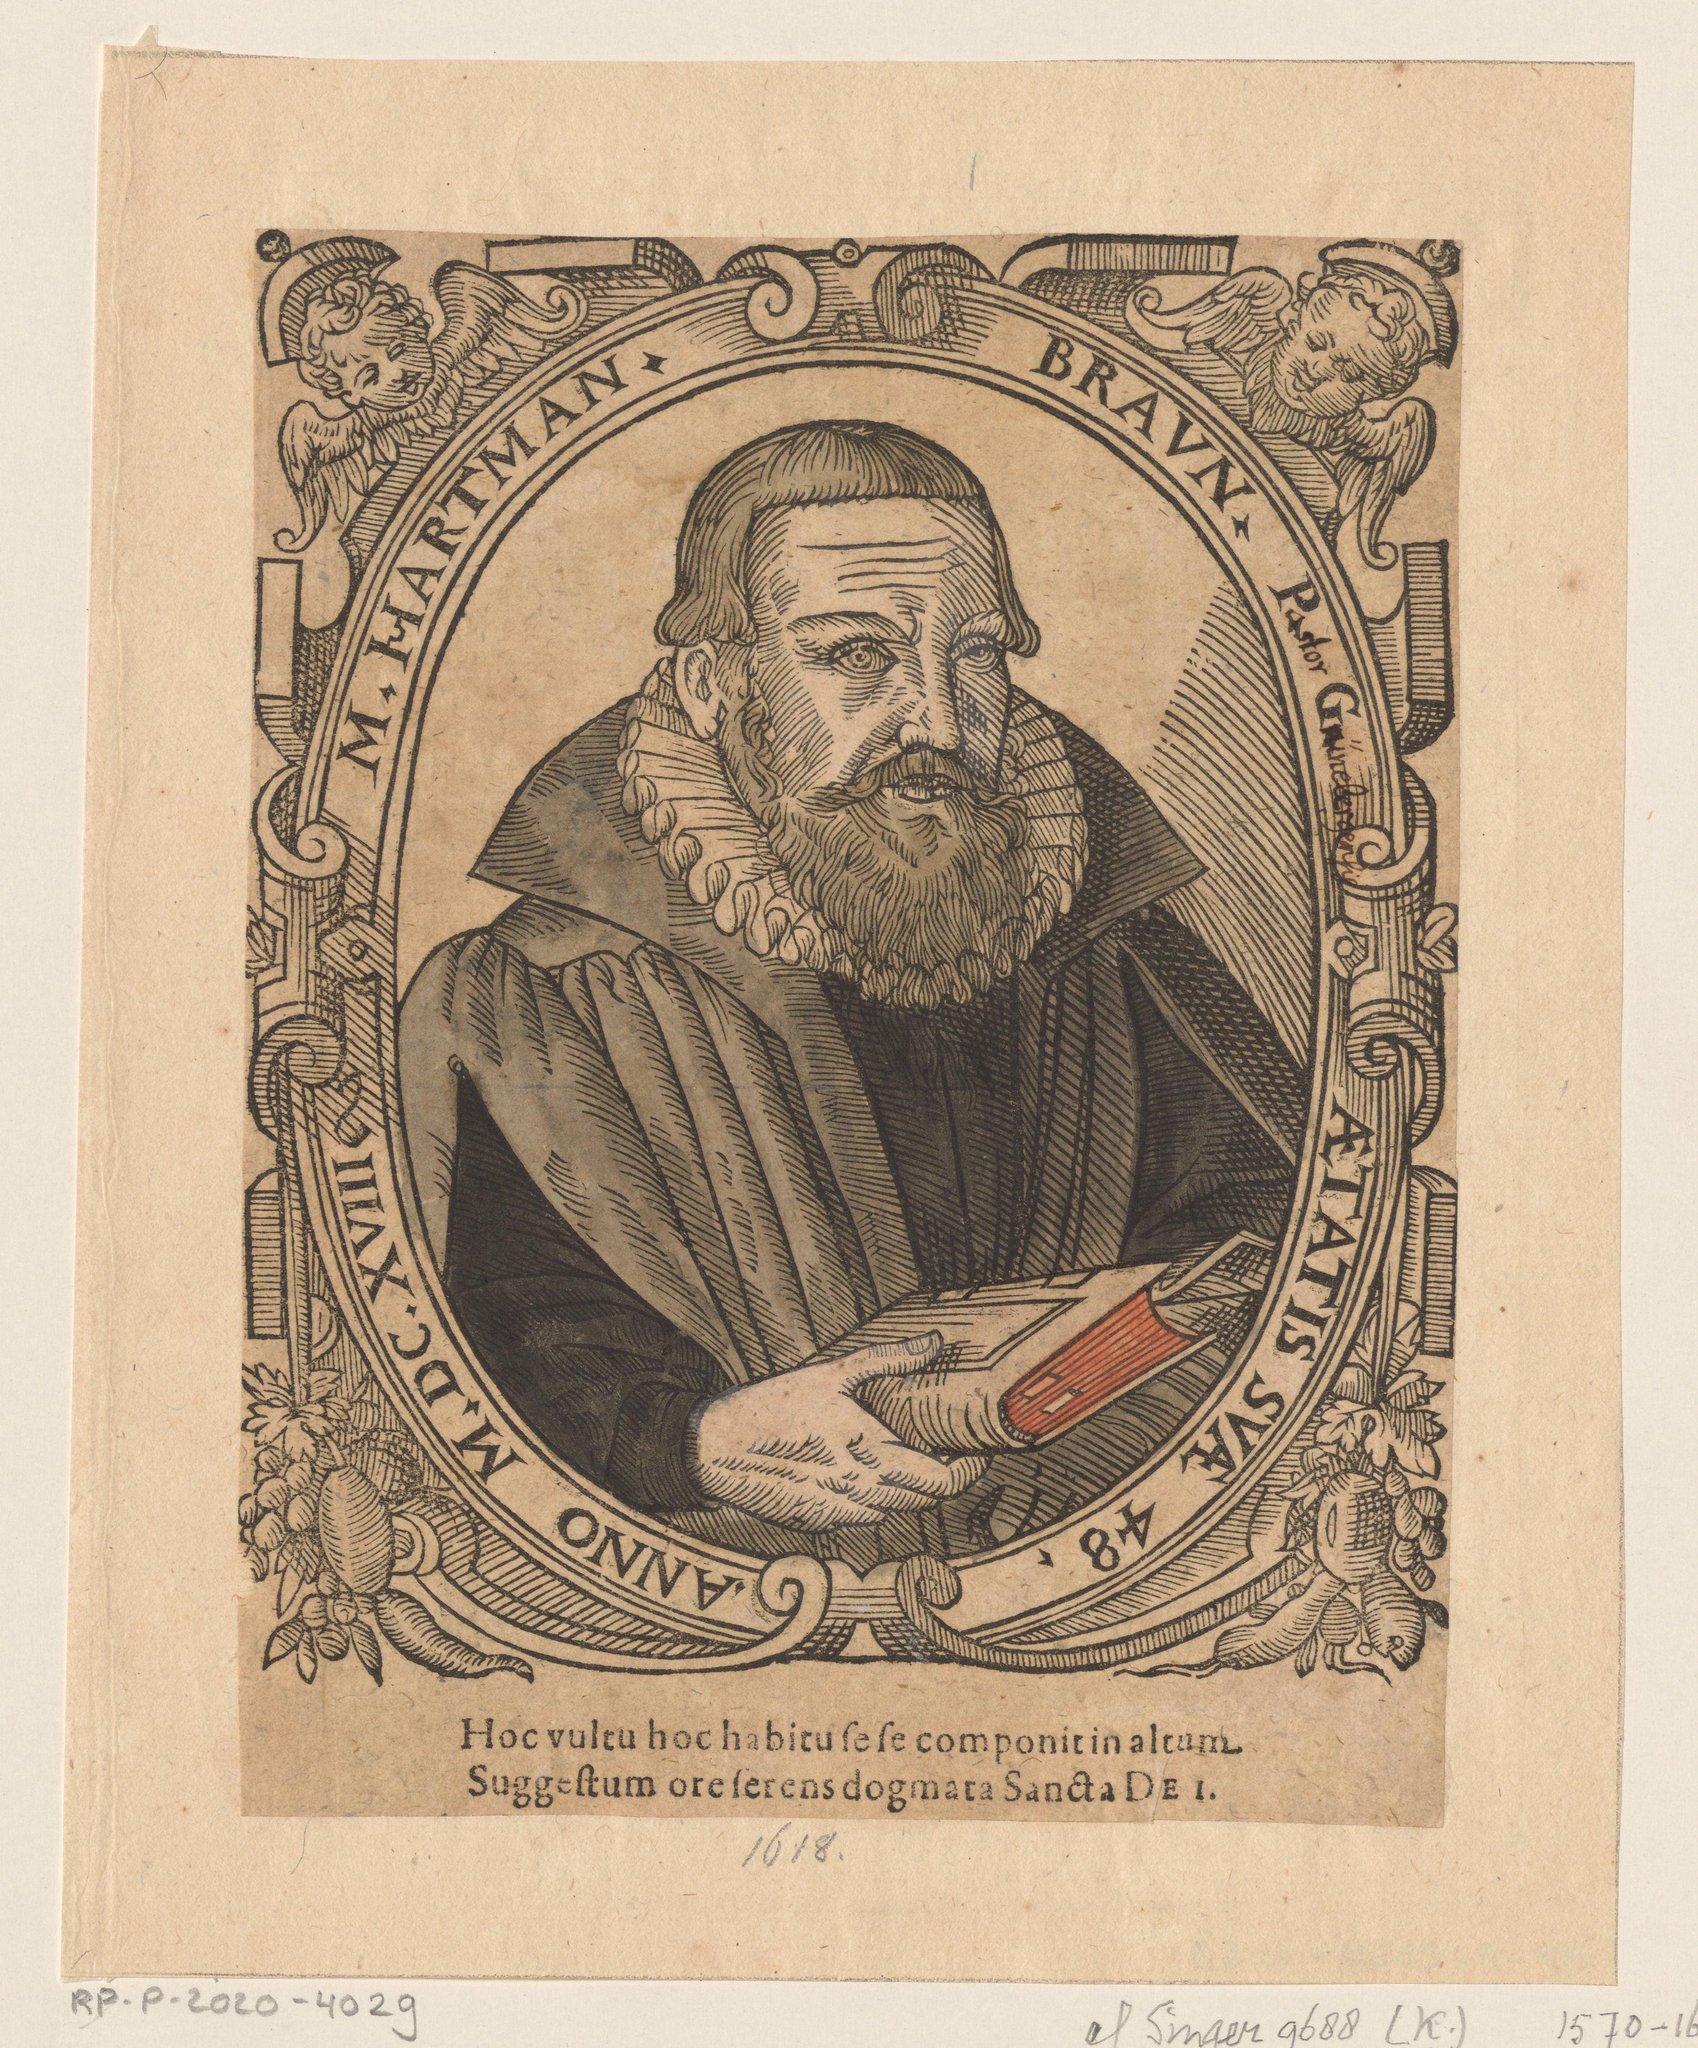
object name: print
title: Portret van Hartmann Braun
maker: Anonymous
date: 1618-1649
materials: paper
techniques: letterpress printing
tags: historical persons, book